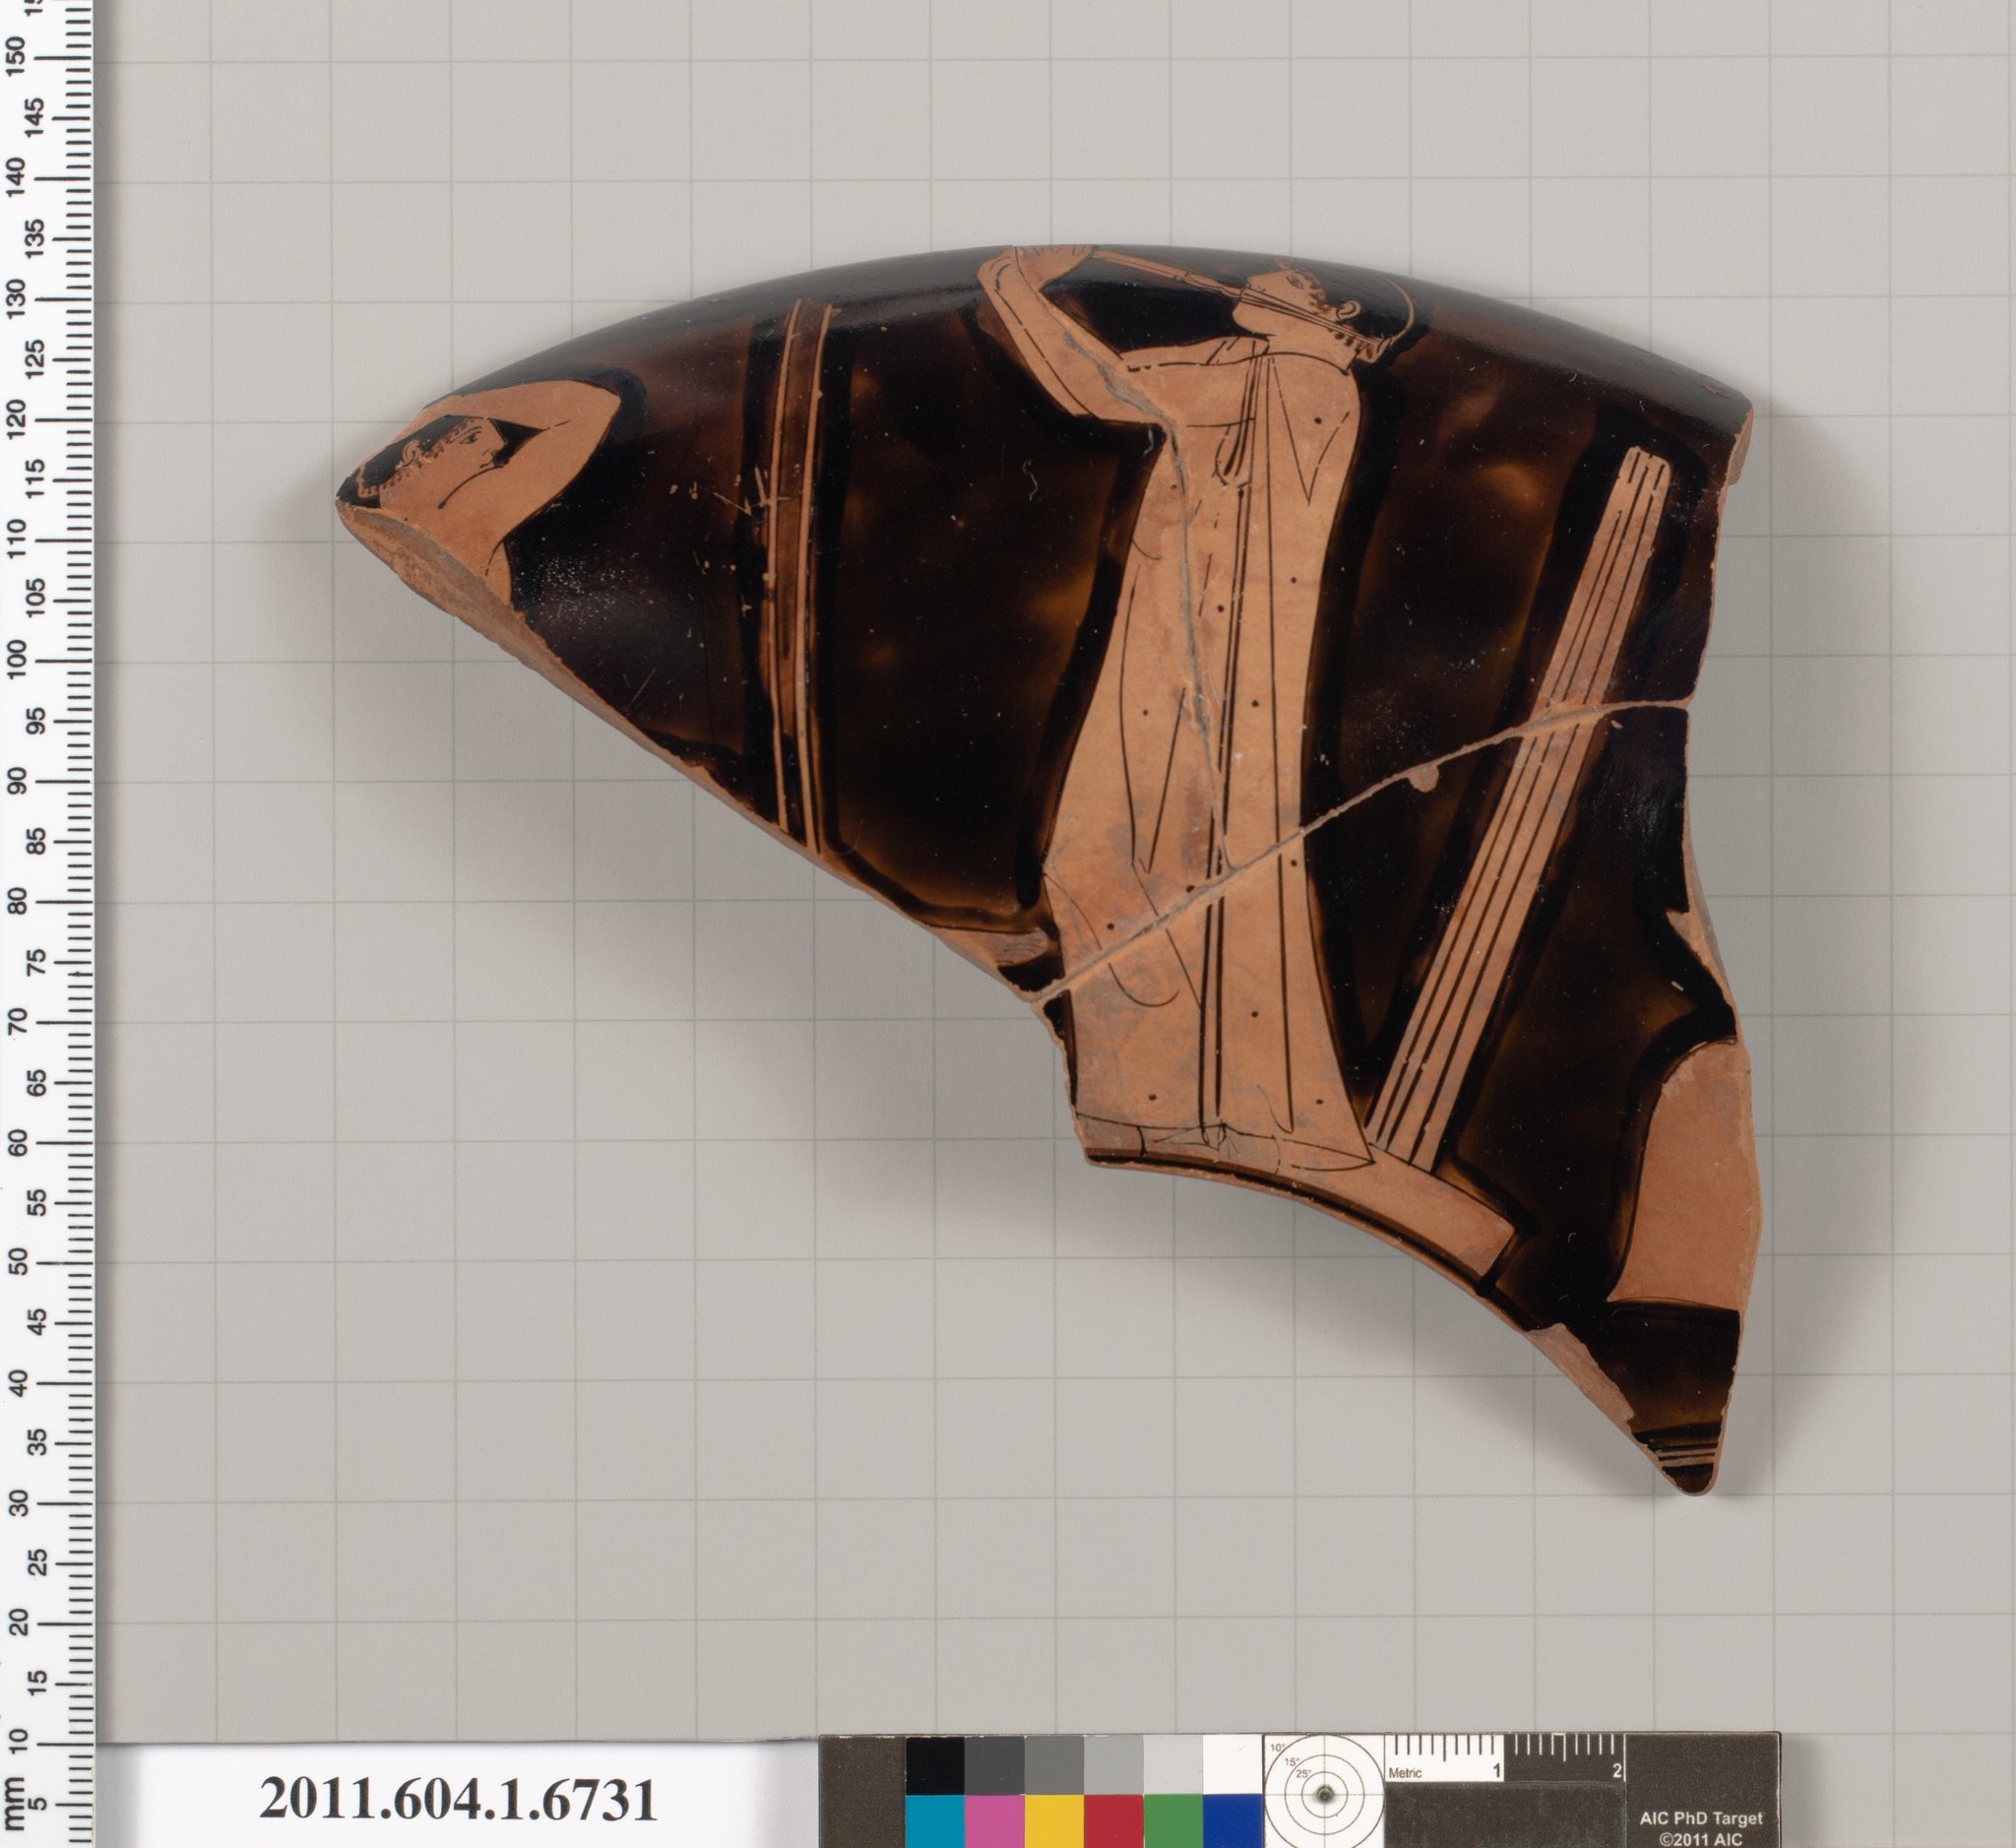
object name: kylix fragment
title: Terracotta rim fragment of a kylix (drinking cup)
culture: greek, attic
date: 490-470 BCE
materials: terracotta